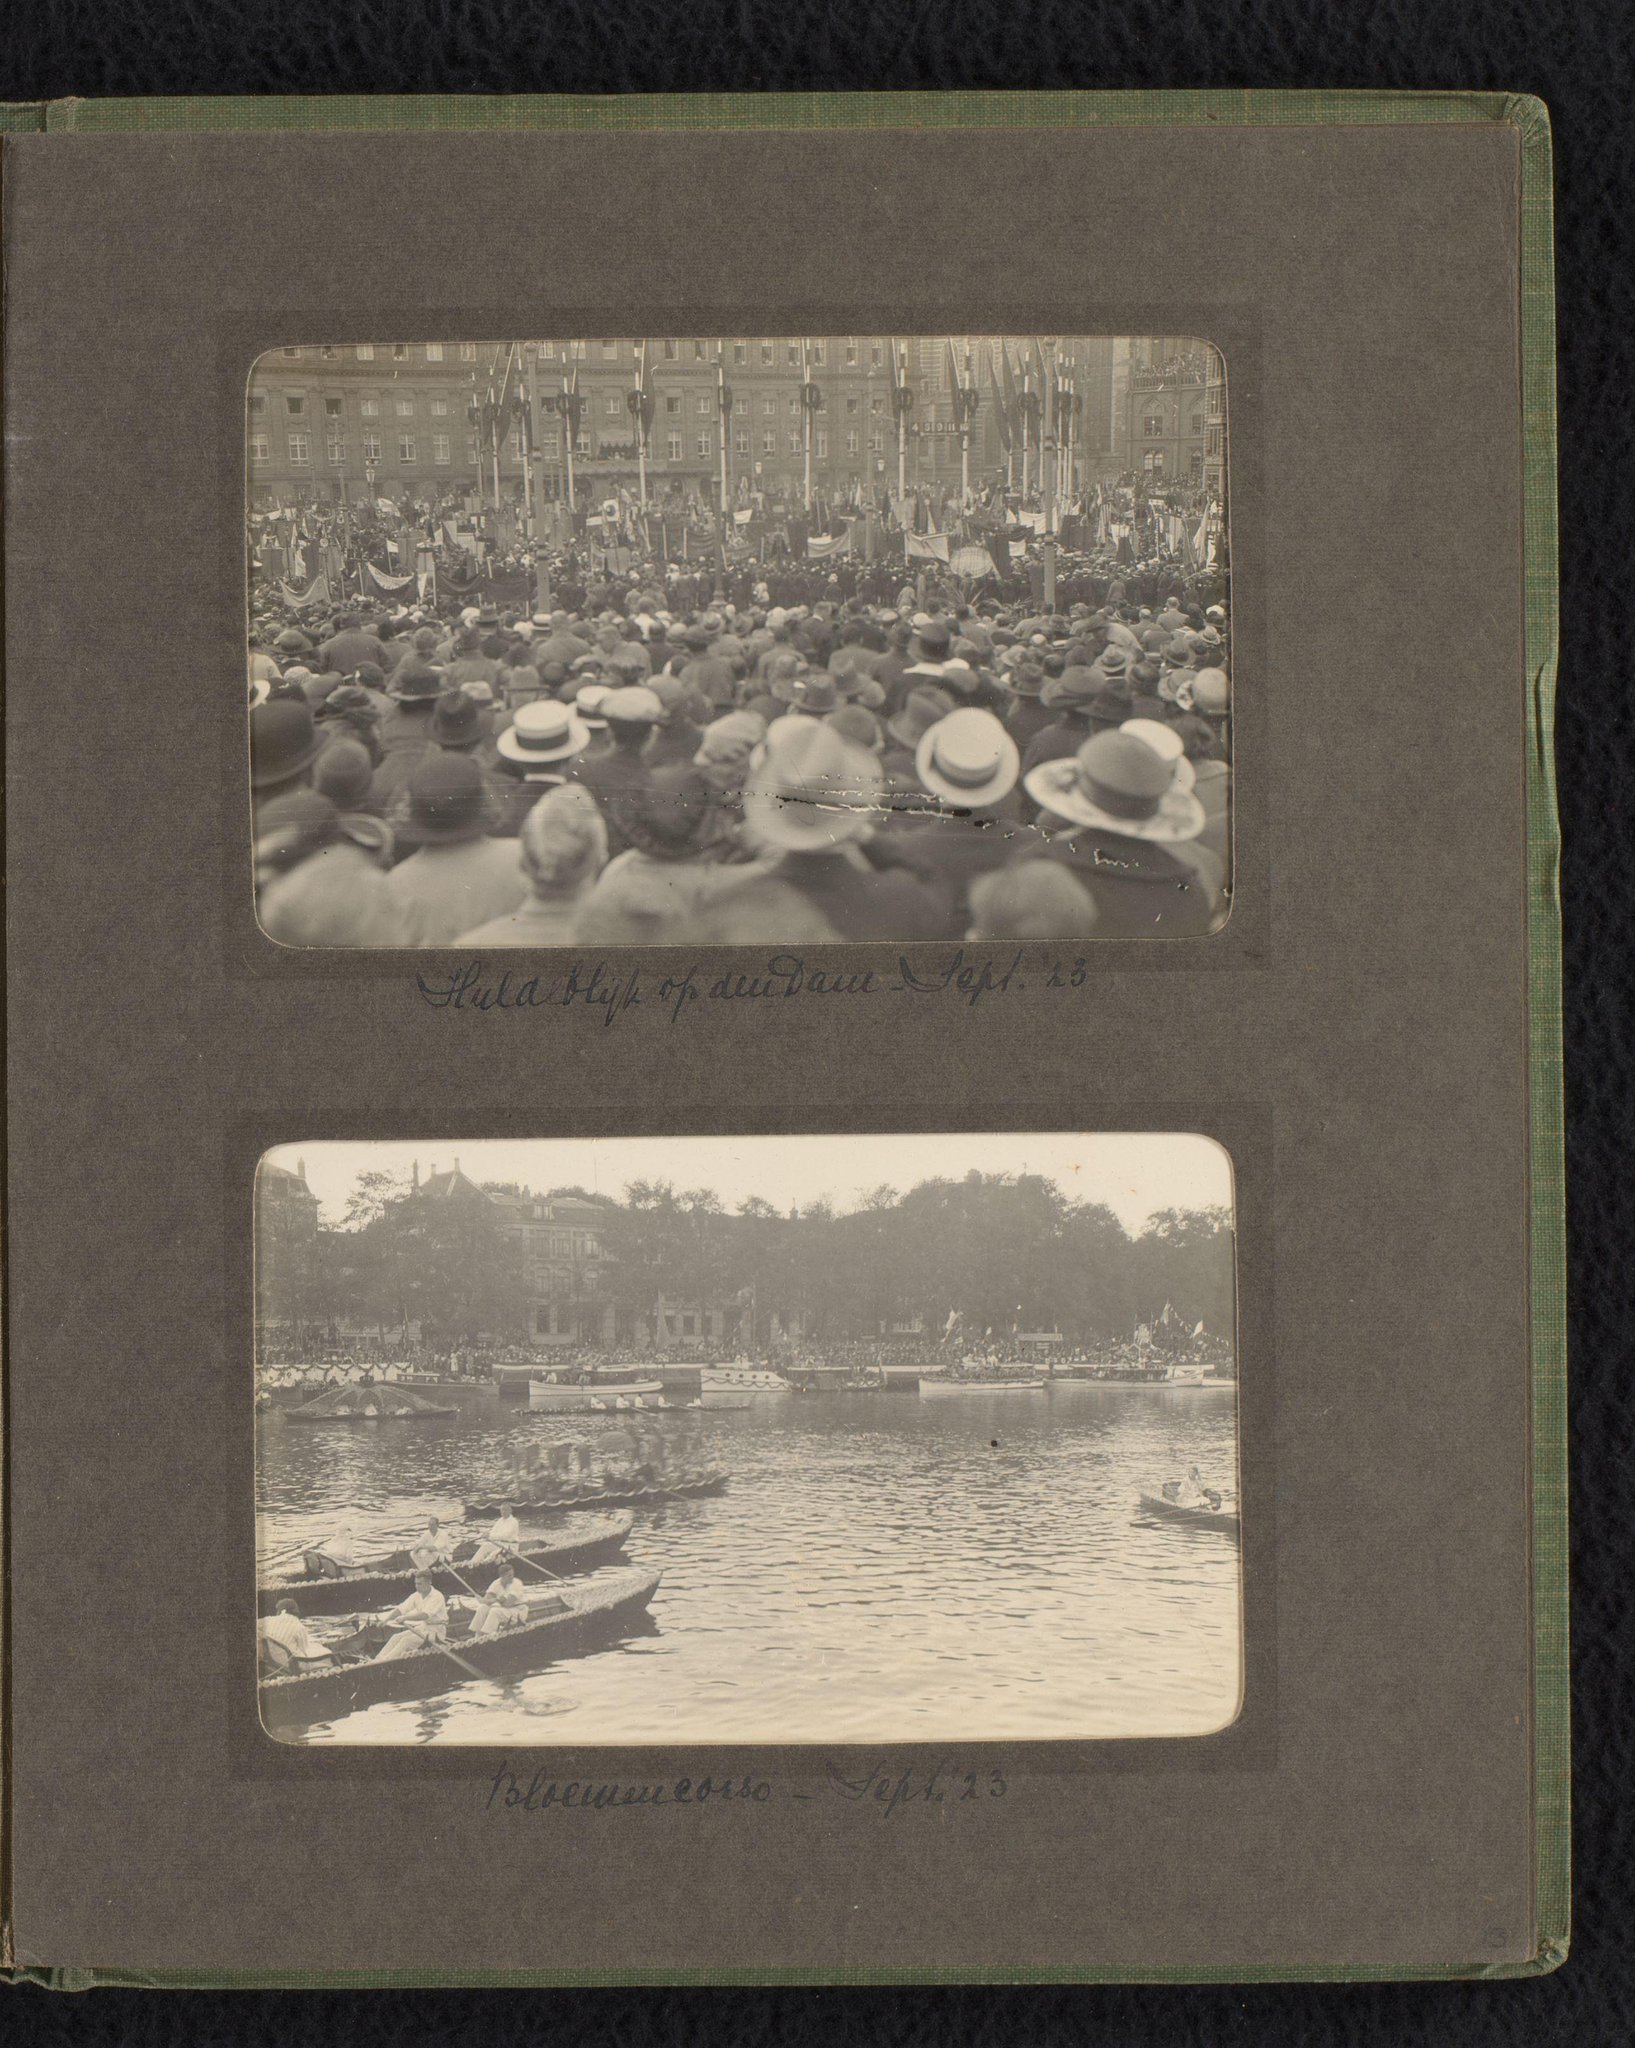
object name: album leaf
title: Twee foto's van feestelijkheden ter gelegenheid van het regeringsjubileum van koningin Wilhelmina in Amsterdam en roeiers tijdens het bloemencorso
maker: hendrik herman van den berg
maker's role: amateurfotograaf, jurist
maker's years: 1875-1944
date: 1909-1923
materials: paper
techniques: gelatin silver print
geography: netherlands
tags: public festivities on the occasion of royal events, rowing-boat, canoe, etc., amsterdam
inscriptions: inscription: ‘Bloemencorso. Sept '23’, inscription: ‘Huldeblijk op den Dam. Sept. '23’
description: Deze foto's maken deel uit van een album.